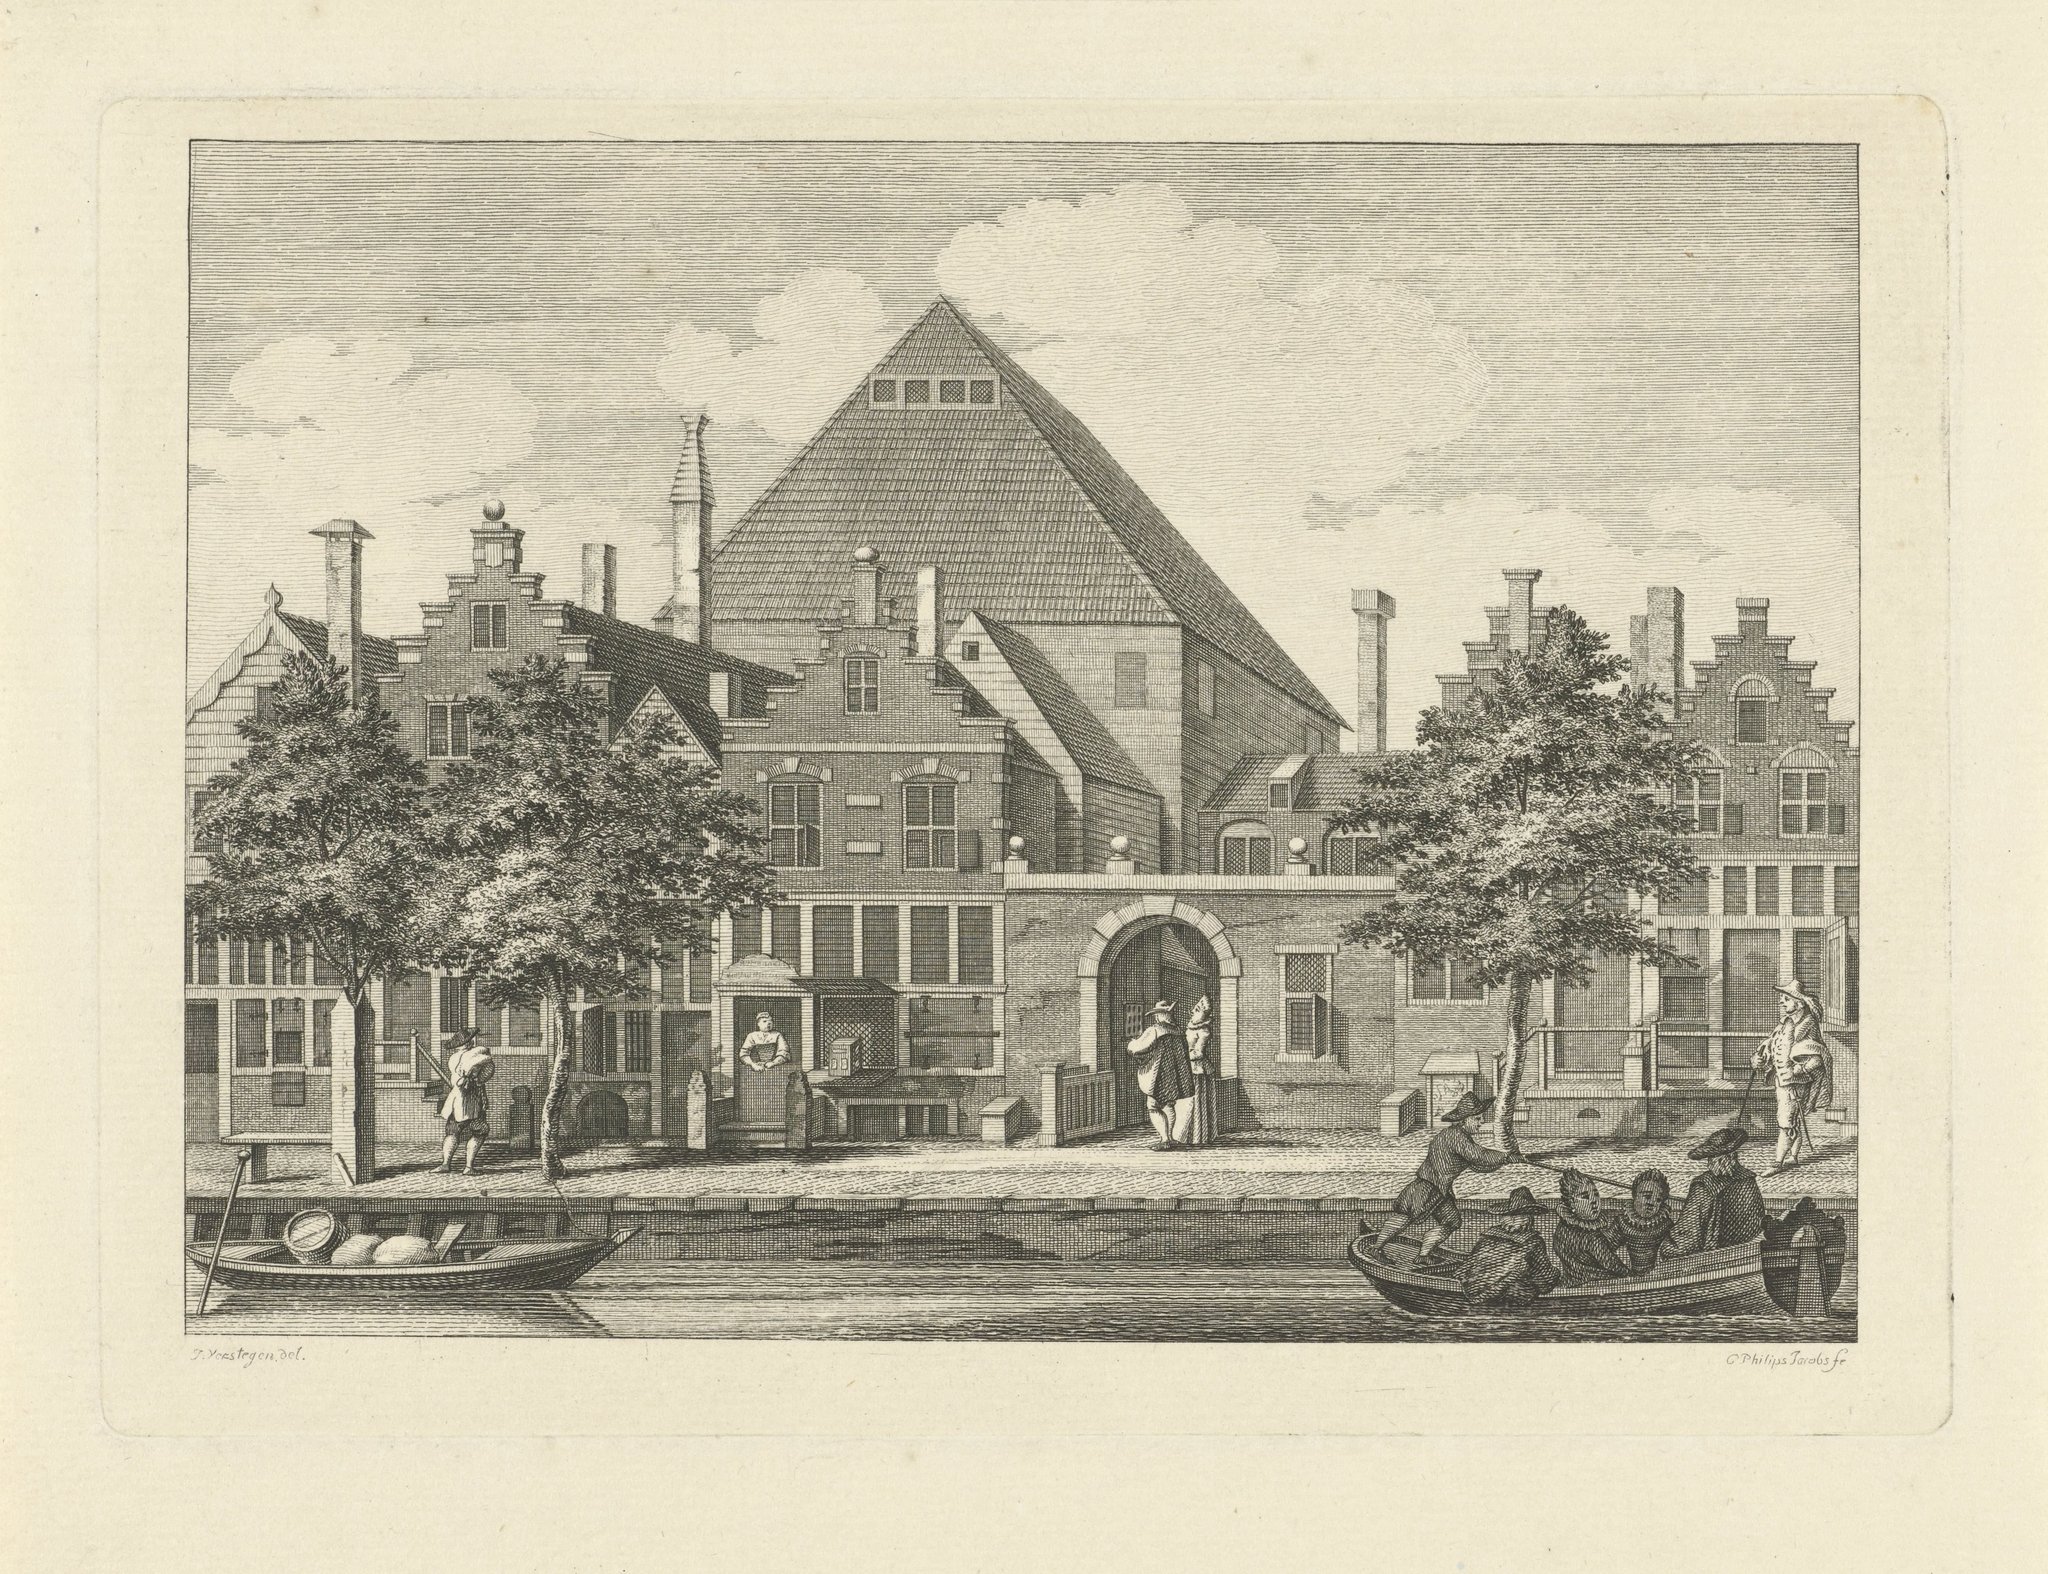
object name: print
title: Gezicht op de Nederduitse Academie van Samuel Coster aan de Keizersgracht, 1617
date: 1752-1789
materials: paper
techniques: etching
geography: amsterdam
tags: samuel coster, theatre (building), canals, waters (in city) (+ city(-scape) with figures, staffage), street (+ city(-scape) with figures, staffage), book-shop, bookseller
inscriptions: collector's mark: Lugt 2228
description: Gezicht op de Nederduitse Academie (Eerste Nederduytsche Academie) van Samuel Coster aan de Keizersgracht te Amsterdam, gelegen ter hoogte van het huidige nummer 384. Zoals het eruit zou hebben gezien in het jaar van oprichting 1617. Links van de toegangspoort een boekwinkel. Op straat en in het bootje rechtsvoor enkele figuren.